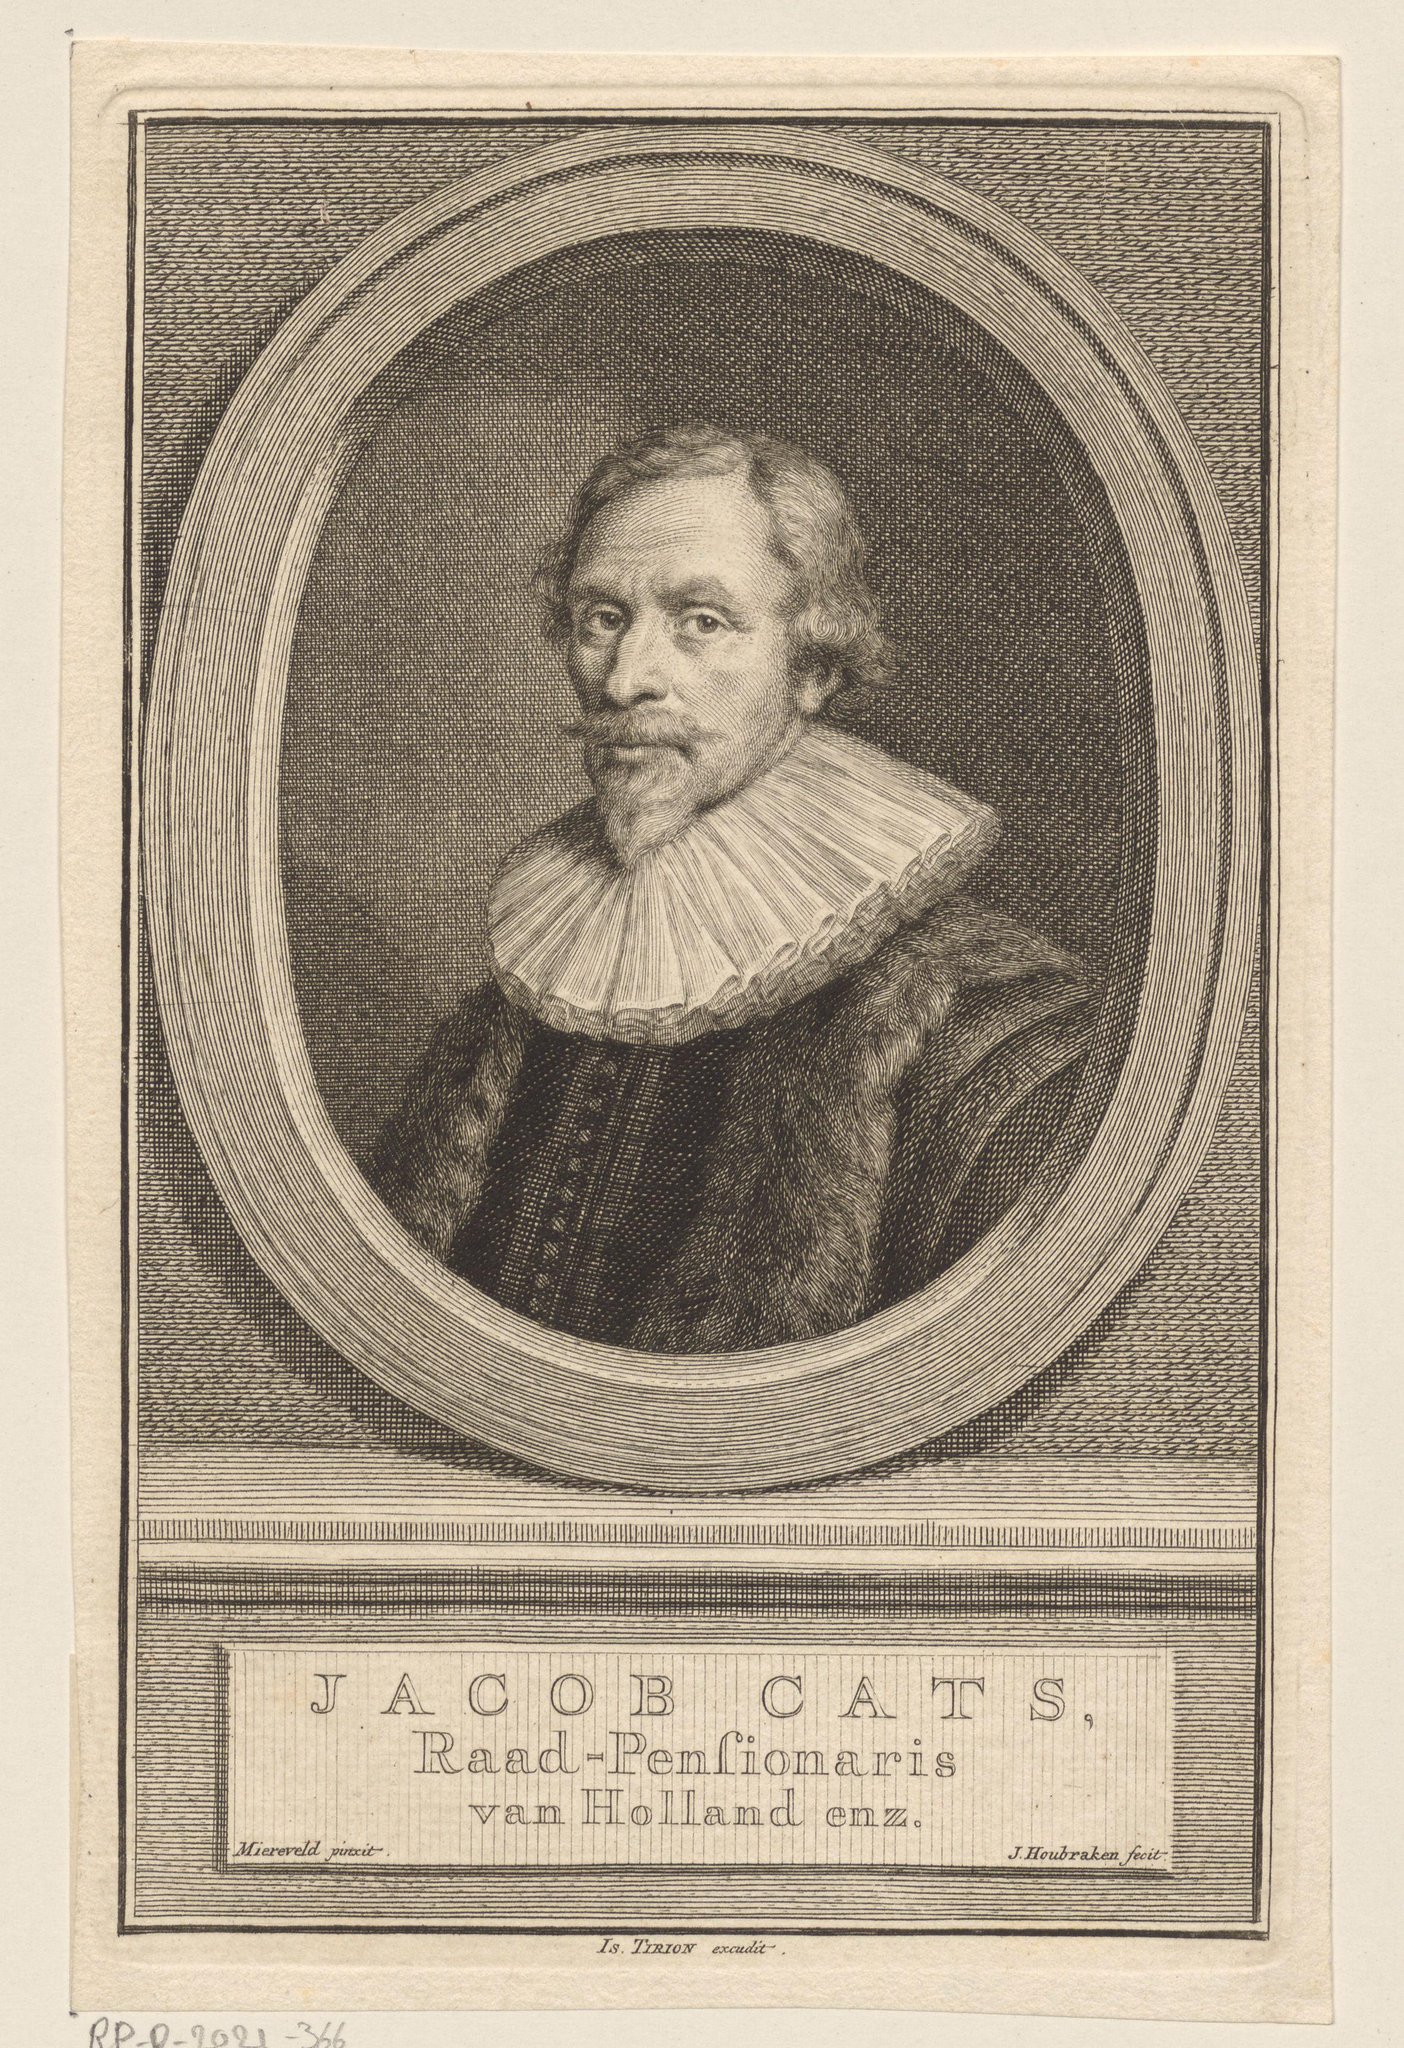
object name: print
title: Portret van Jacob Cats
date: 1749-1794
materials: paper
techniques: engraving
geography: amsterdam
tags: the hague, jacob cats (1577-1660), historical persons, portrait of a writer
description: Prent mogelijk uit: Wagenaar, Jan. Vaderlandsche historie, vervattende de geschiedenissen der nu Vereenigde Nederlanden, inzonderheid die van Holland (...). 21 dln. Amsterdam: Isaak Tirion, 1749-59. Of een latere editie (1794).